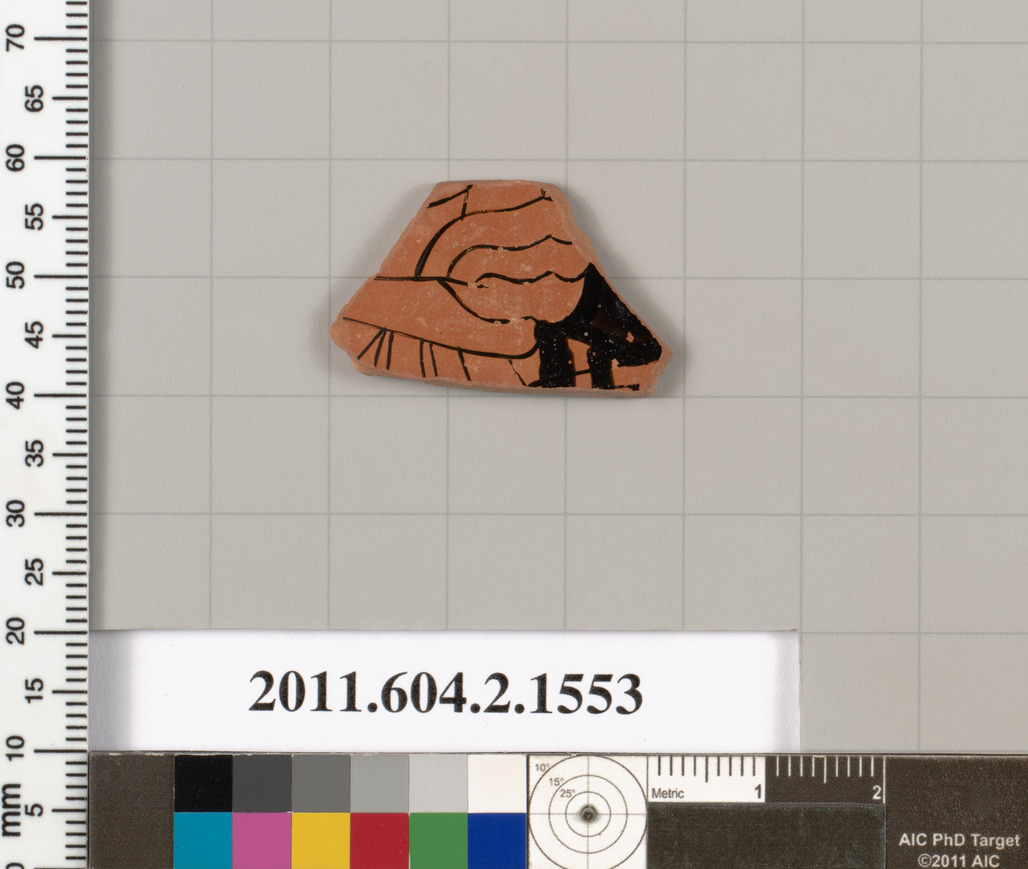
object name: skyphos fragment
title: Terracotta fragment of a skyphos (deep drinking cup)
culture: greek, attic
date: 470-460 BCE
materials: terracotta